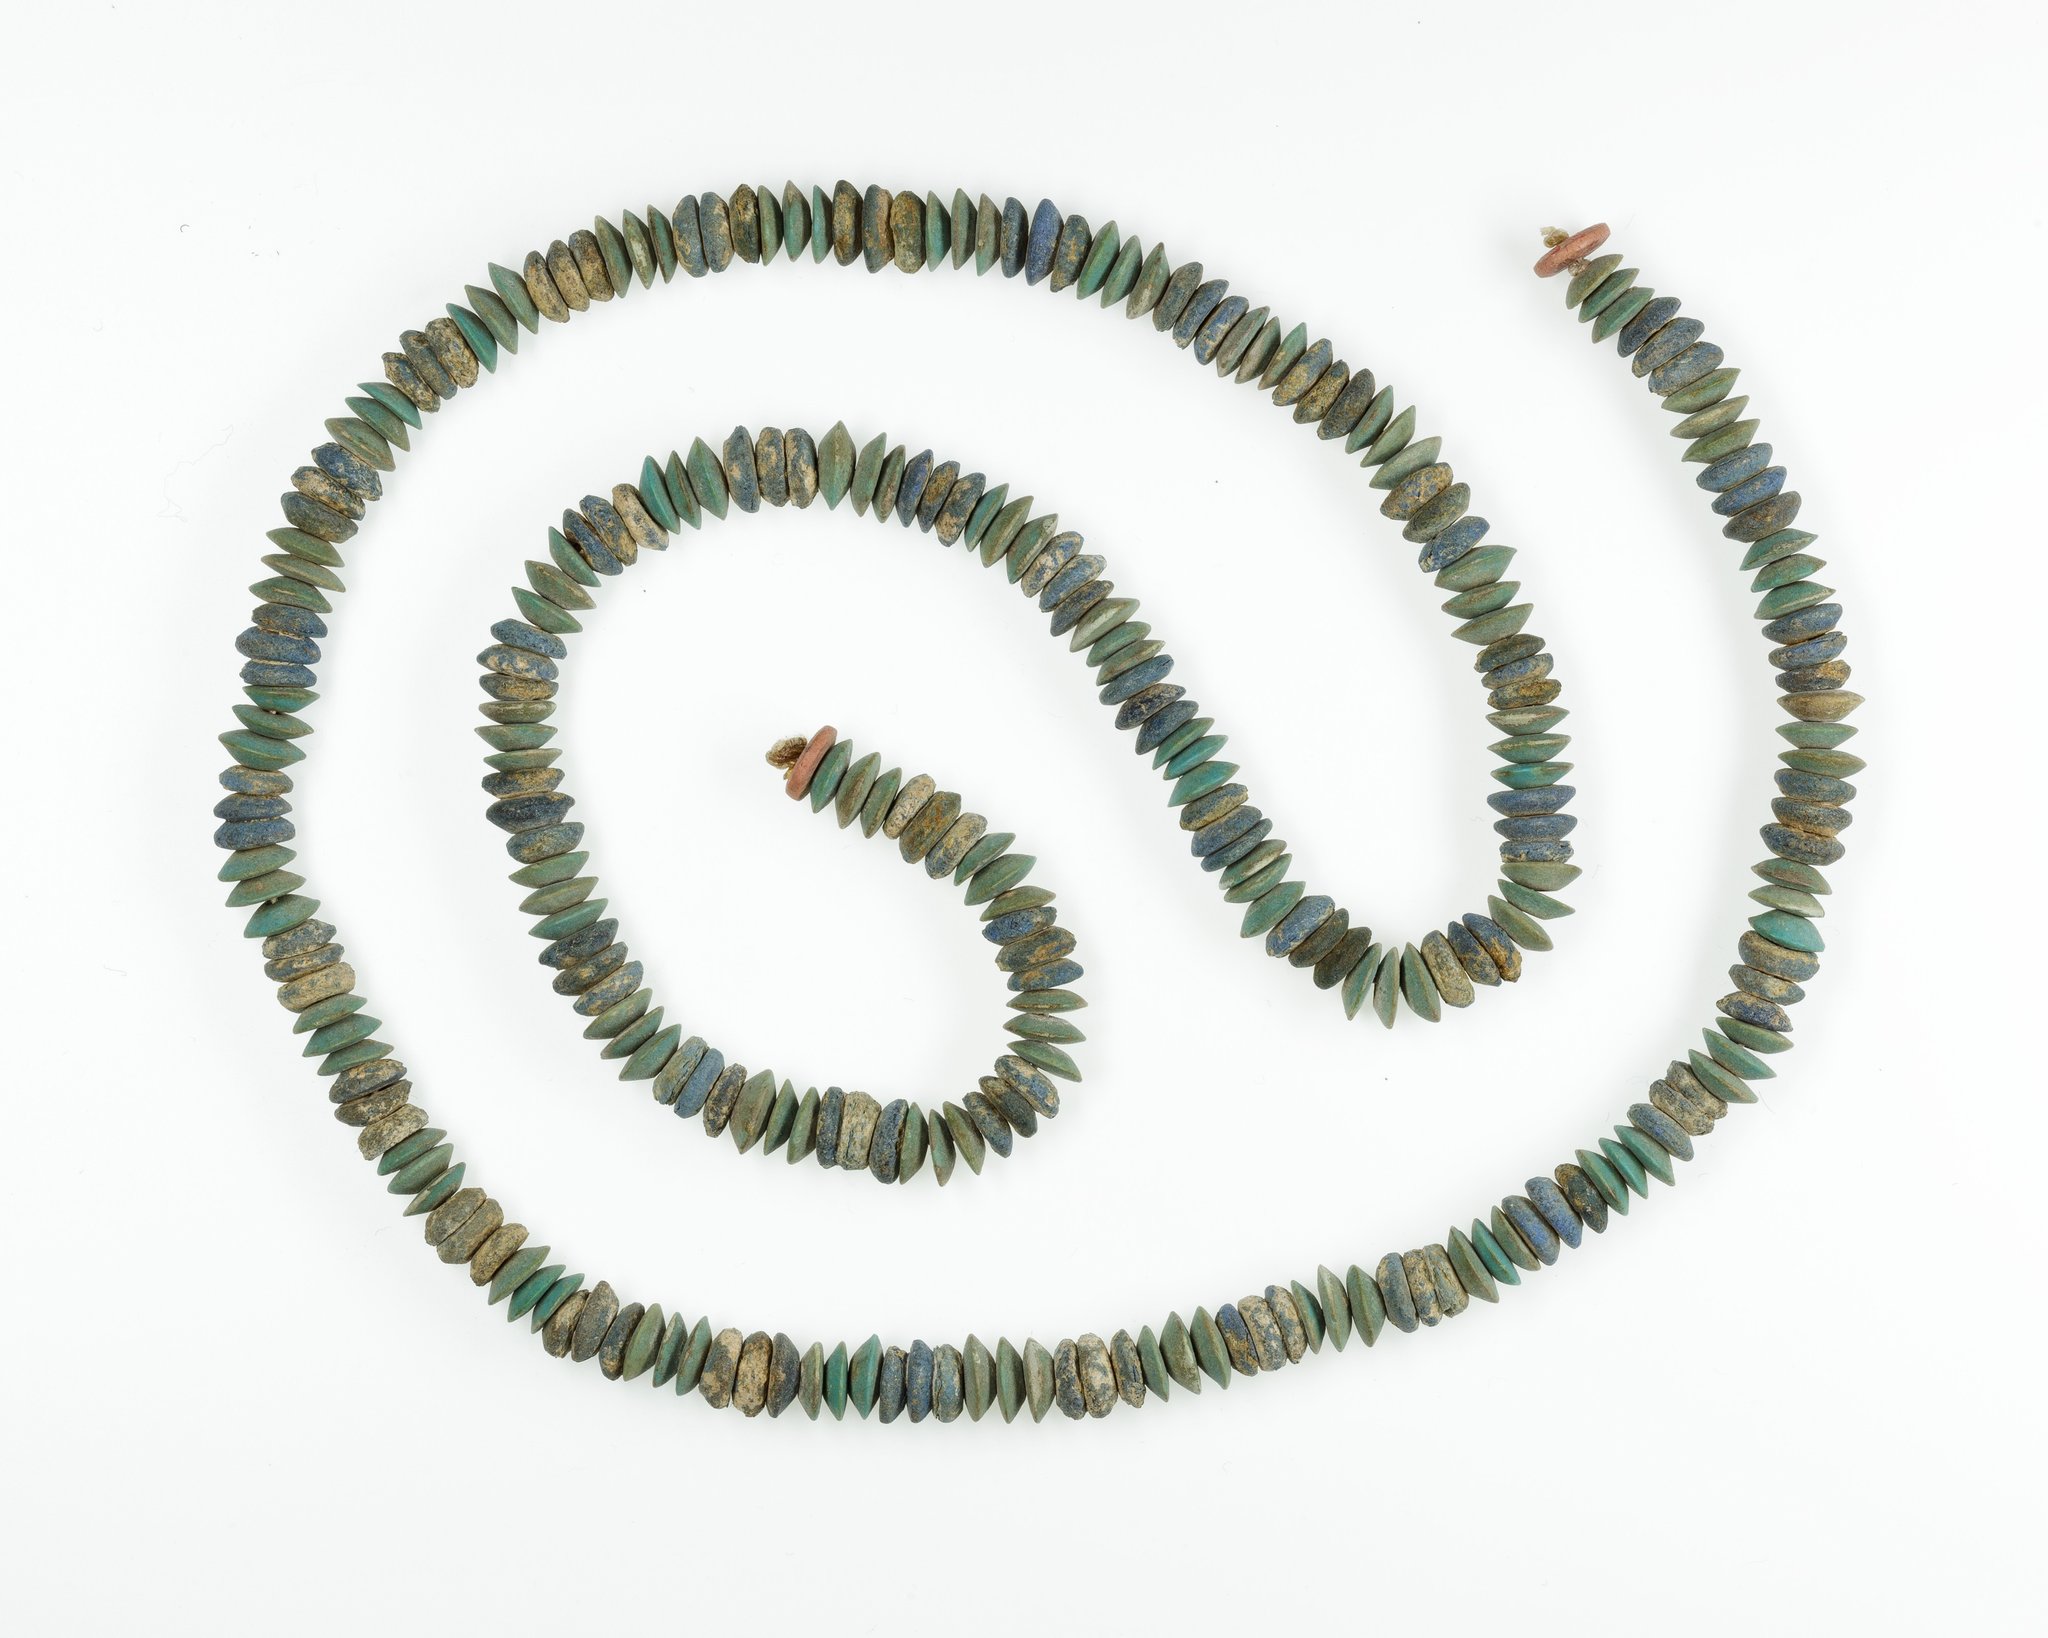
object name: necklace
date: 1786-1482 BCE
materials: faience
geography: egypt